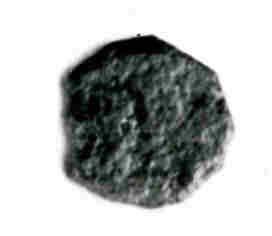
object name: coin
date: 601-1400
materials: copper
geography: iran